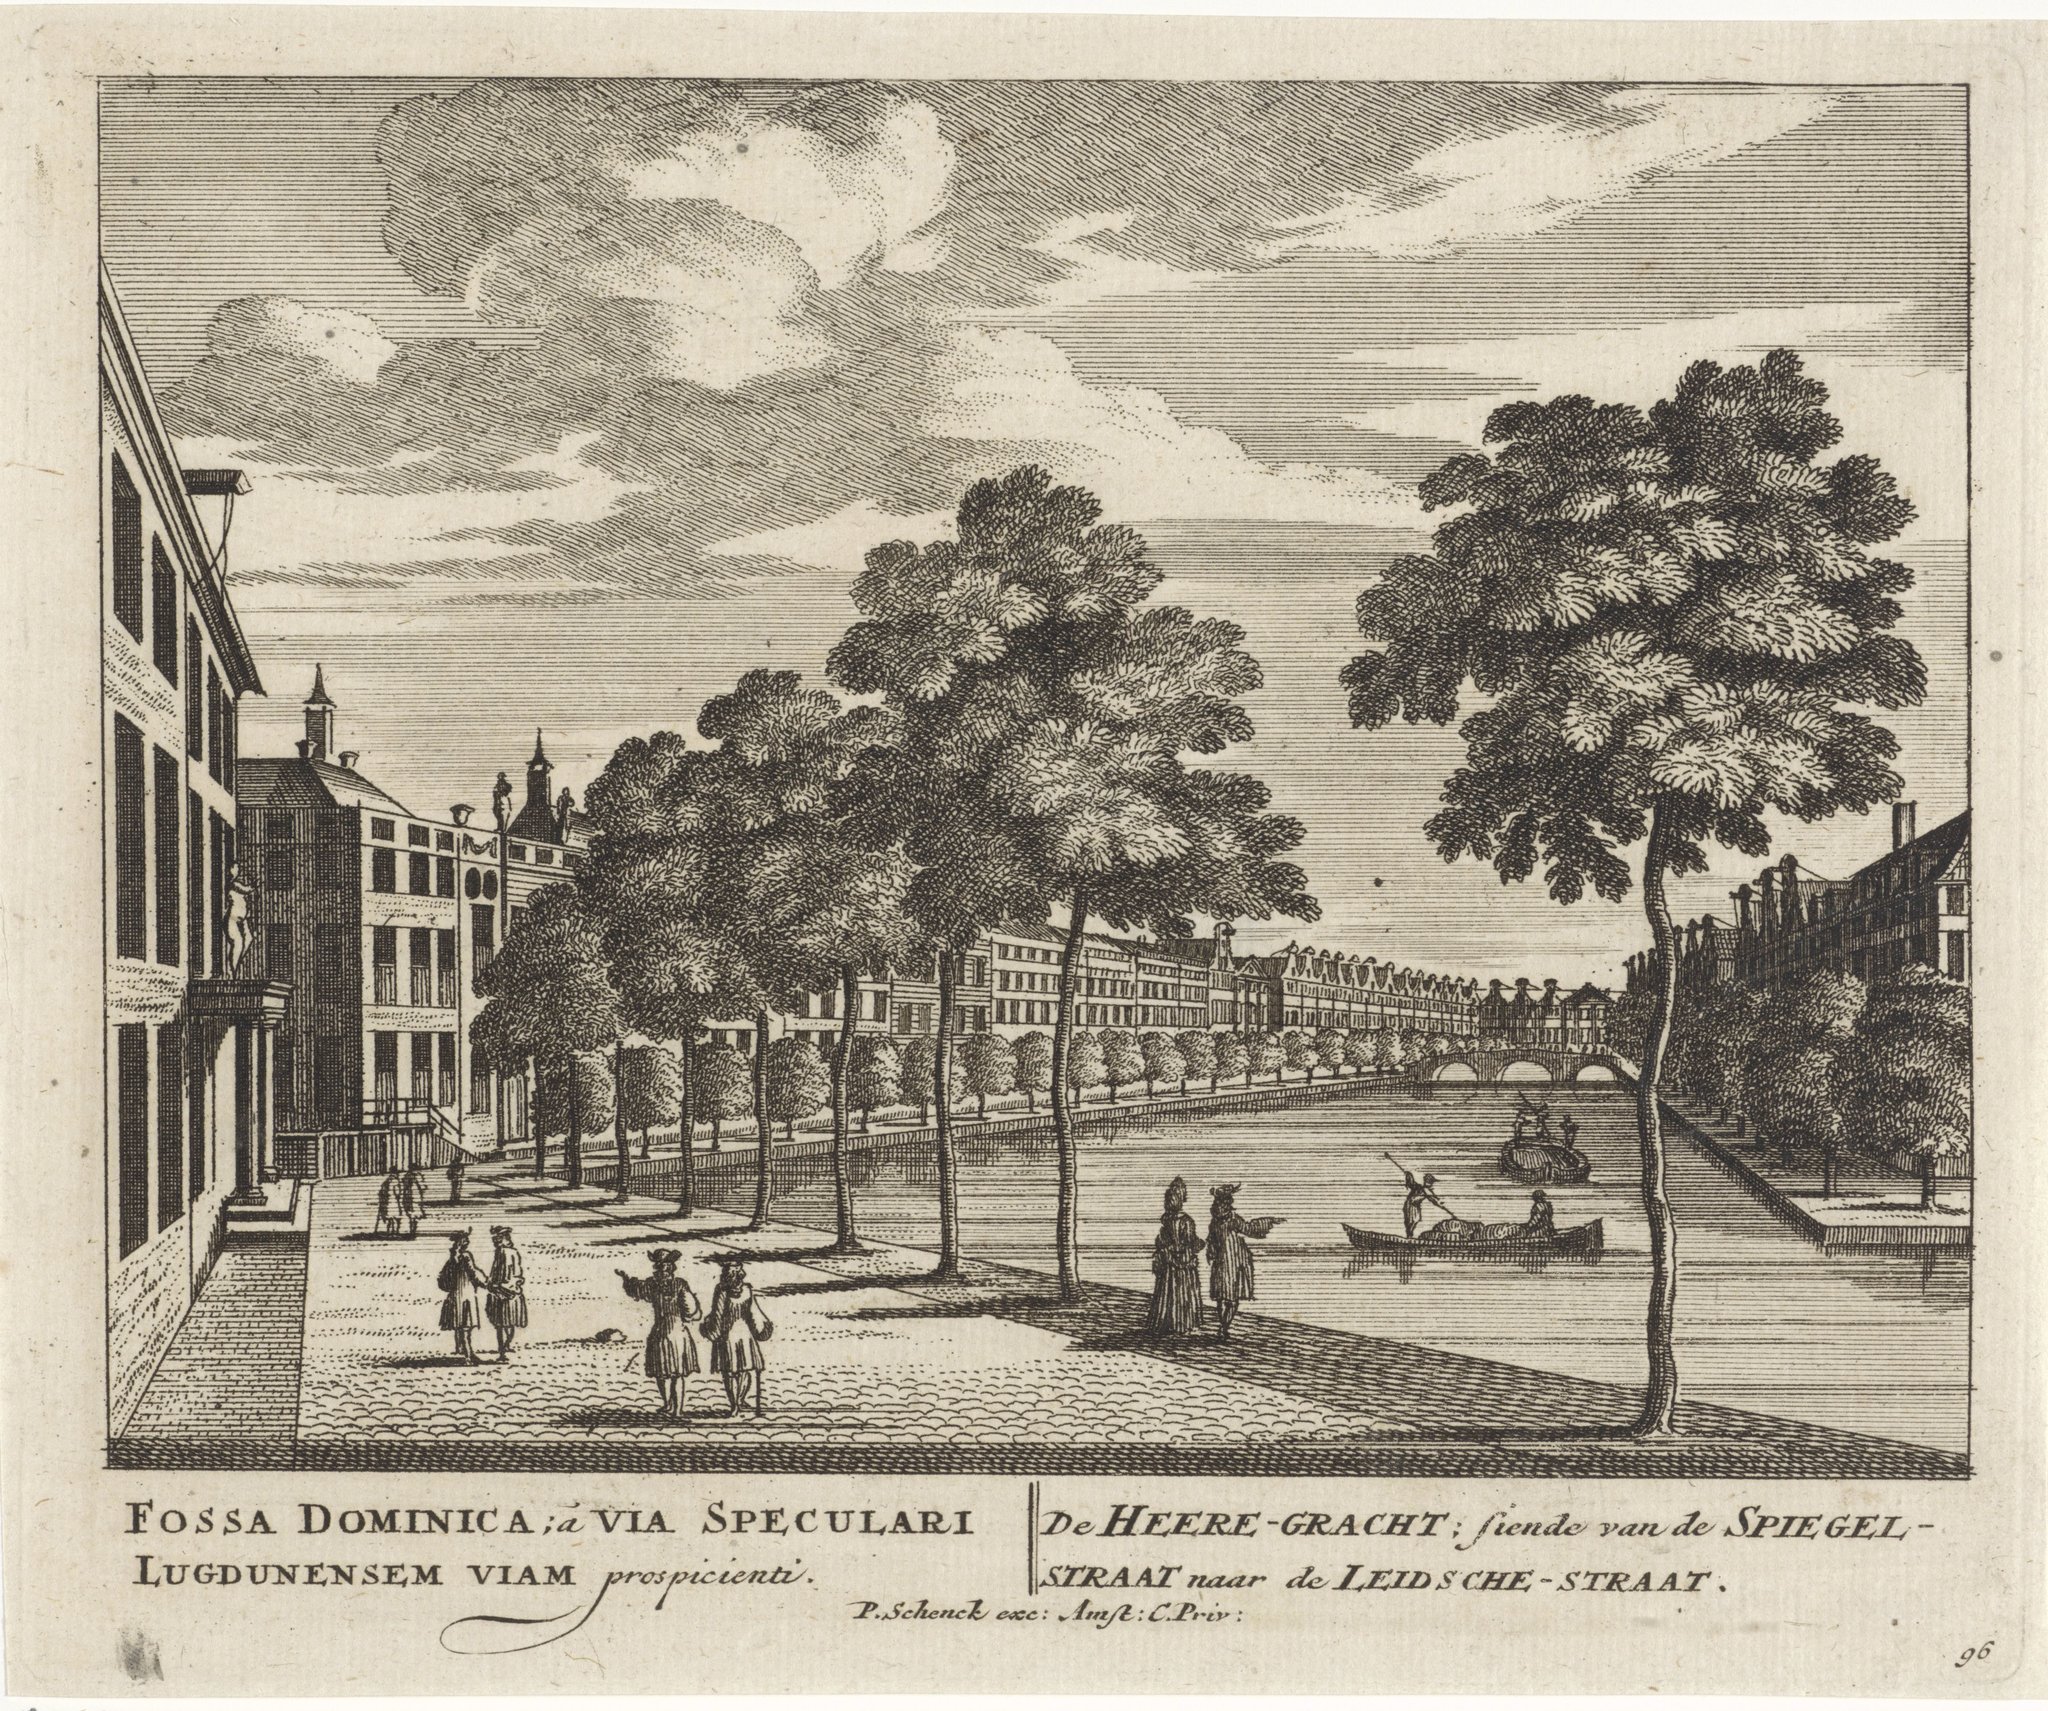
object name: print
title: Gezicht op de Herengracht te Amsterdam, gezien richting de Leidsestraat (Gouden Bocht)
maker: Anonymous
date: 1710-1711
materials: paper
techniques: engraving, etching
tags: canals, waters (in city) (+ city(-scape) with figures, staffage), street (+ city(-scape) with figures, staffage)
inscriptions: collector's mark: Lugt 2228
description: Huidige staat van prent ook gebruikt in: 100 Afbeeldinge der voornaamste gebouwen van Amsterdam. Amsterdam, Pieter Schenk (I), s.a. [1710-1711]. En in: 100 Afbeeldinge der voornaamste gebouwen van Amsterdam. Amsterdam, Barent Greve, s.a. [1757-1766].* *In de tweede uitgave, uitgegeven door Barent Greve, is alleen de titelprent aangepast. De overige prenten zijn onveranderd gebleven.